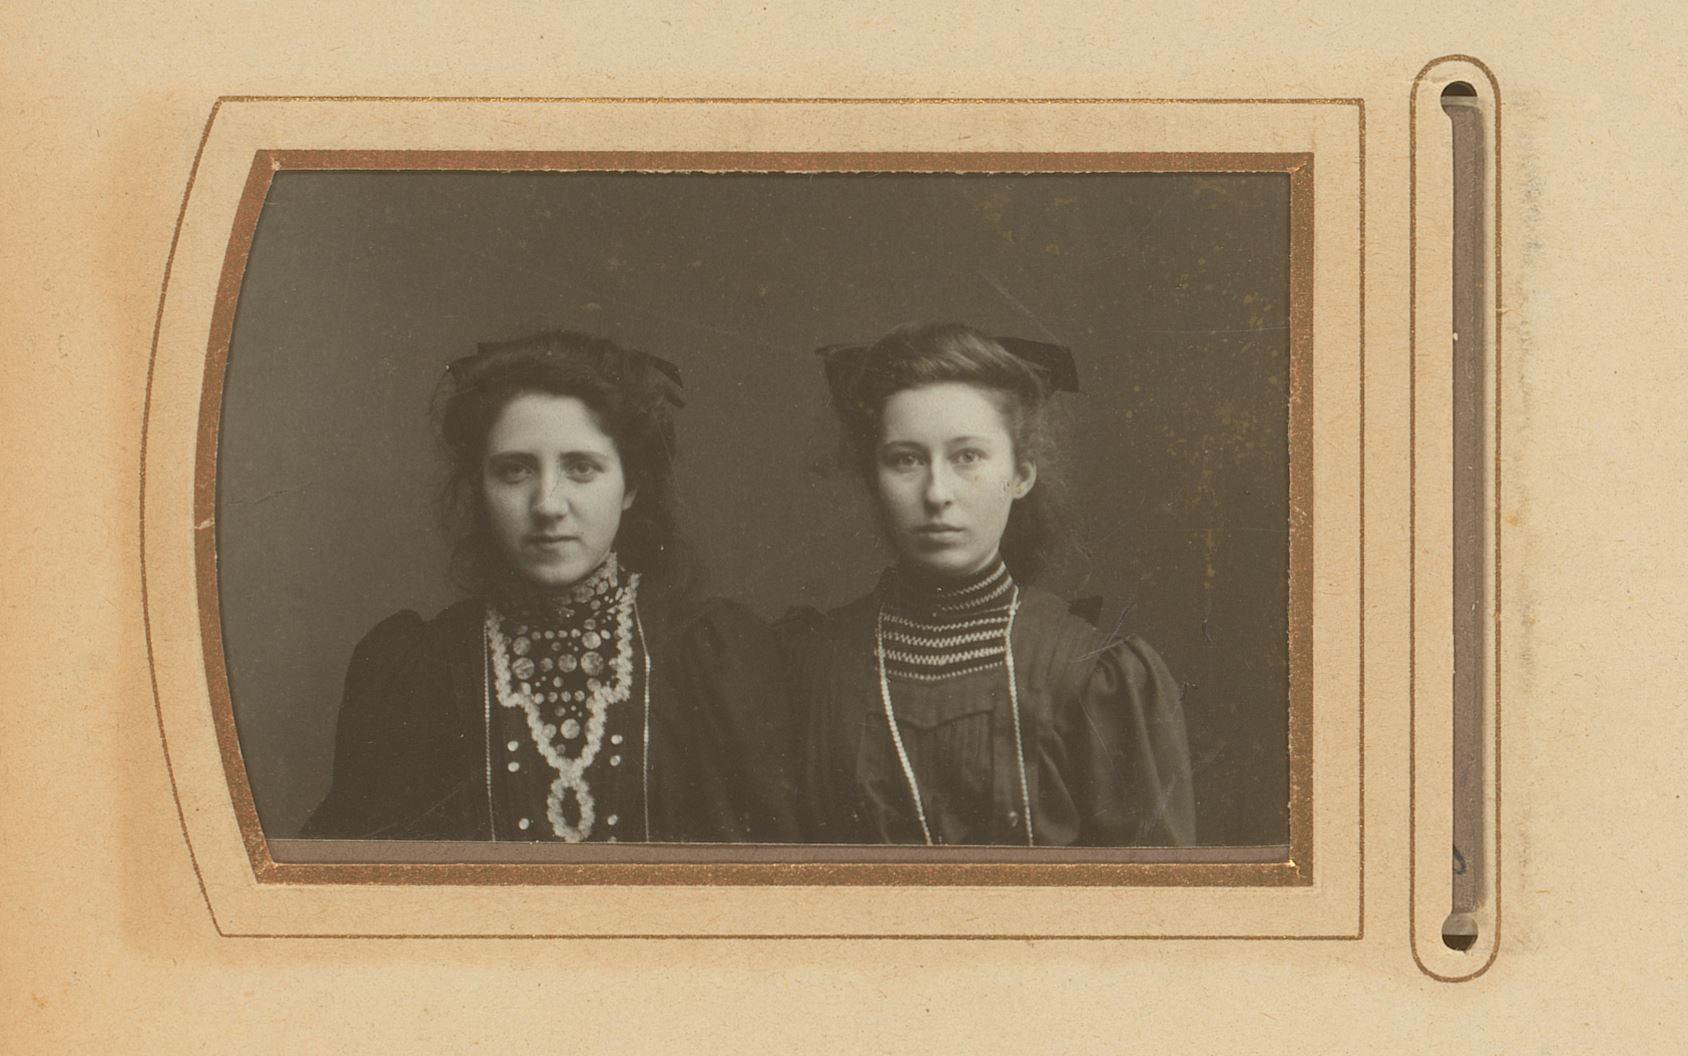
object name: photograph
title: Portret van twee vrouwen, aangeduid als Griet v.d. Tol en Tini van 't Veen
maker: jan bouman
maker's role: fotograaf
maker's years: 1881-1955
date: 1906-1908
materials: cardboard, photographic support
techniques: collodion silver print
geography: apeldoorn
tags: adolescent, young woman, maiden, historical persons - bb - woman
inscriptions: inscription: ‘J. Bouman/ Apeldoorn’, annotation: ‘Griet v.d. Tol en Tini van 't Veen/ (Kweekschool)’